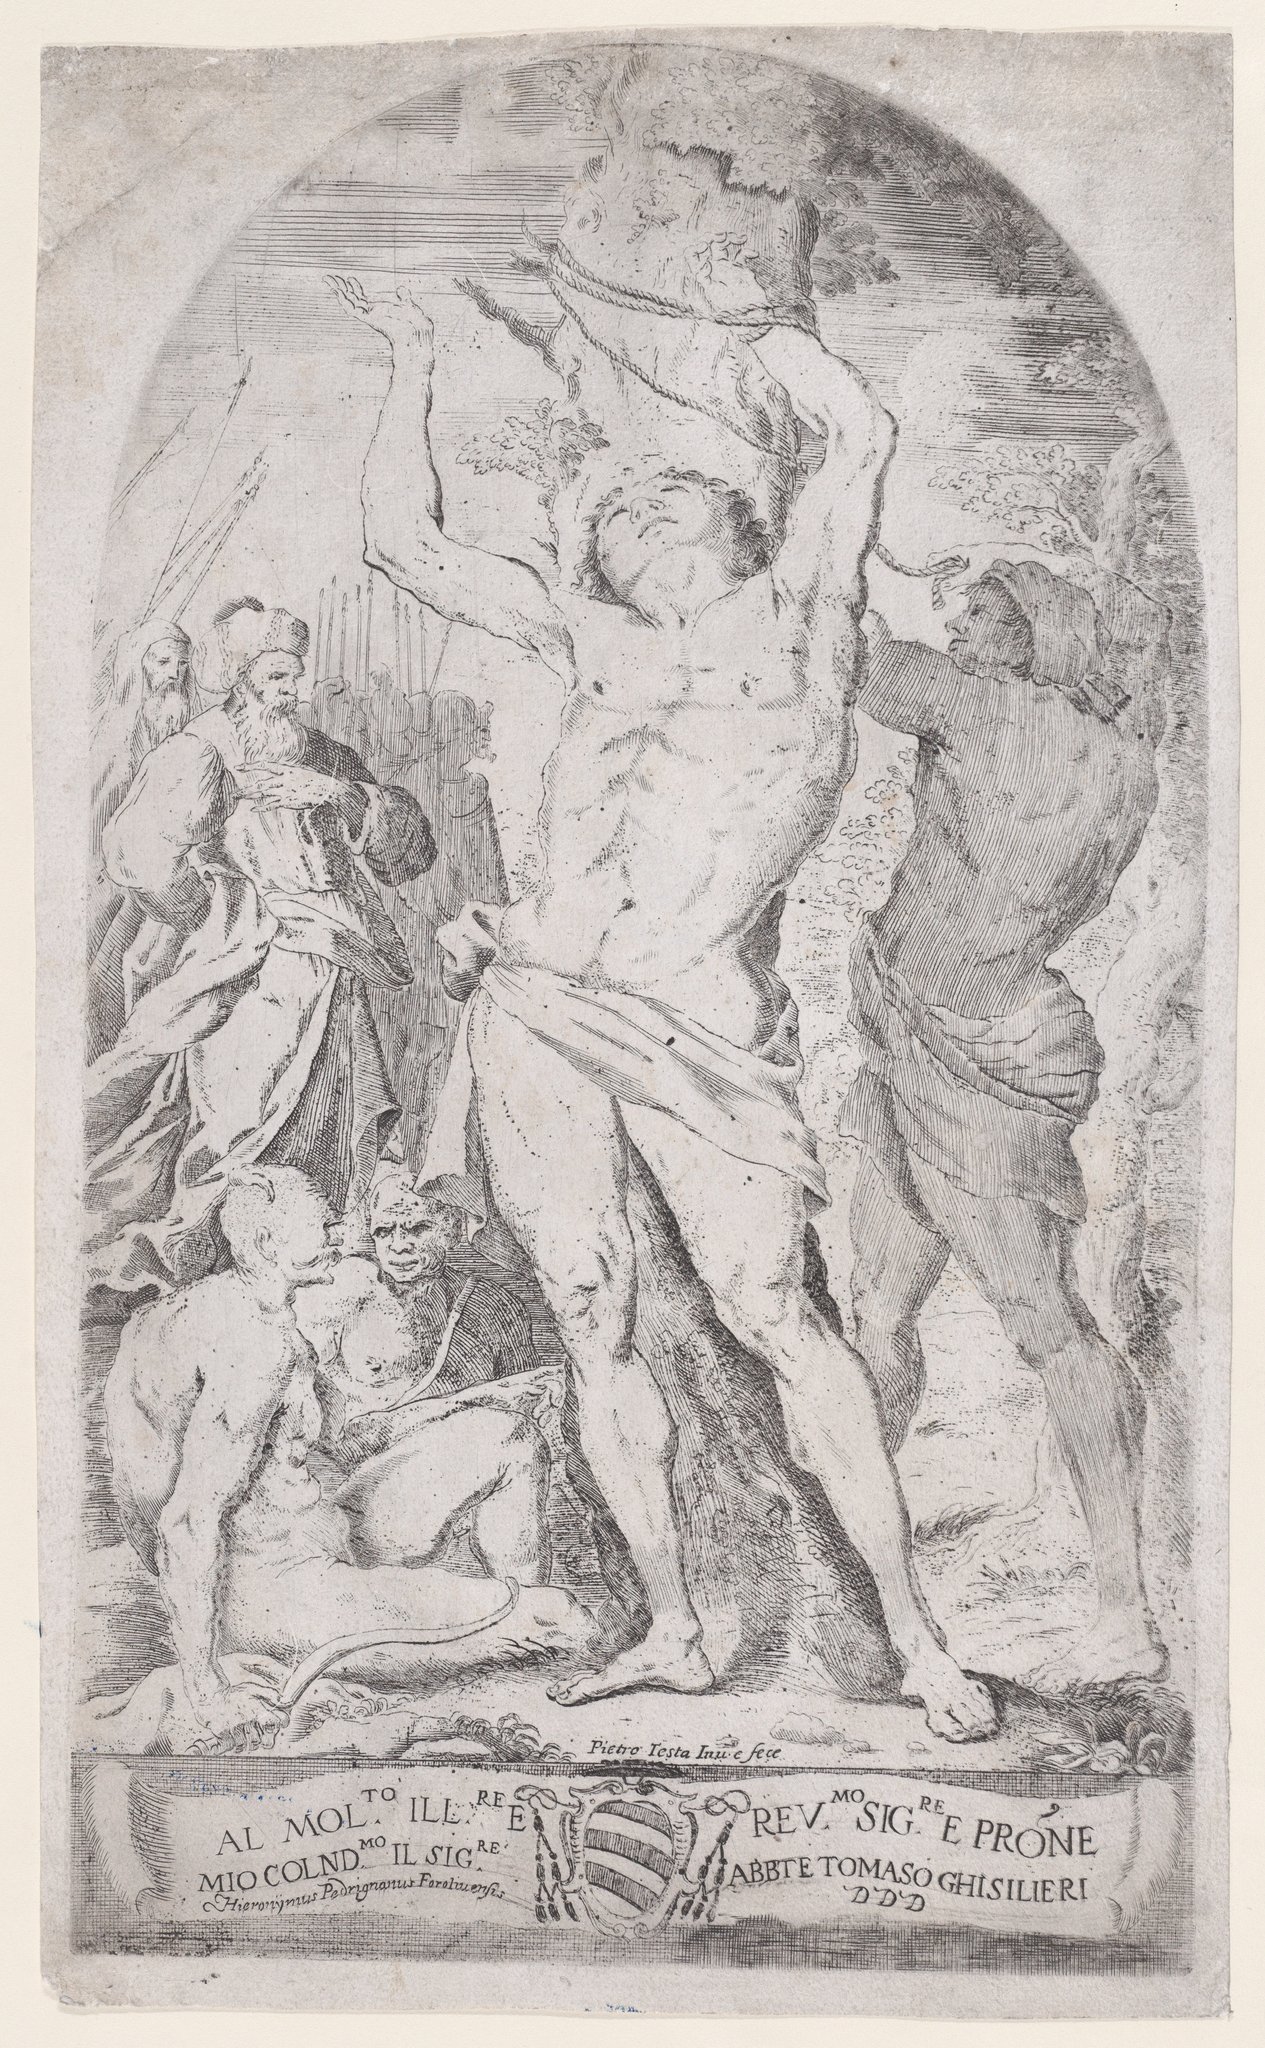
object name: print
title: Saint Sebastian being tied to a tree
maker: girolamo pedrignani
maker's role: artist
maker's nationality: italian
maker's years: 1625-1650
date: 1625-1650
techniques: etching